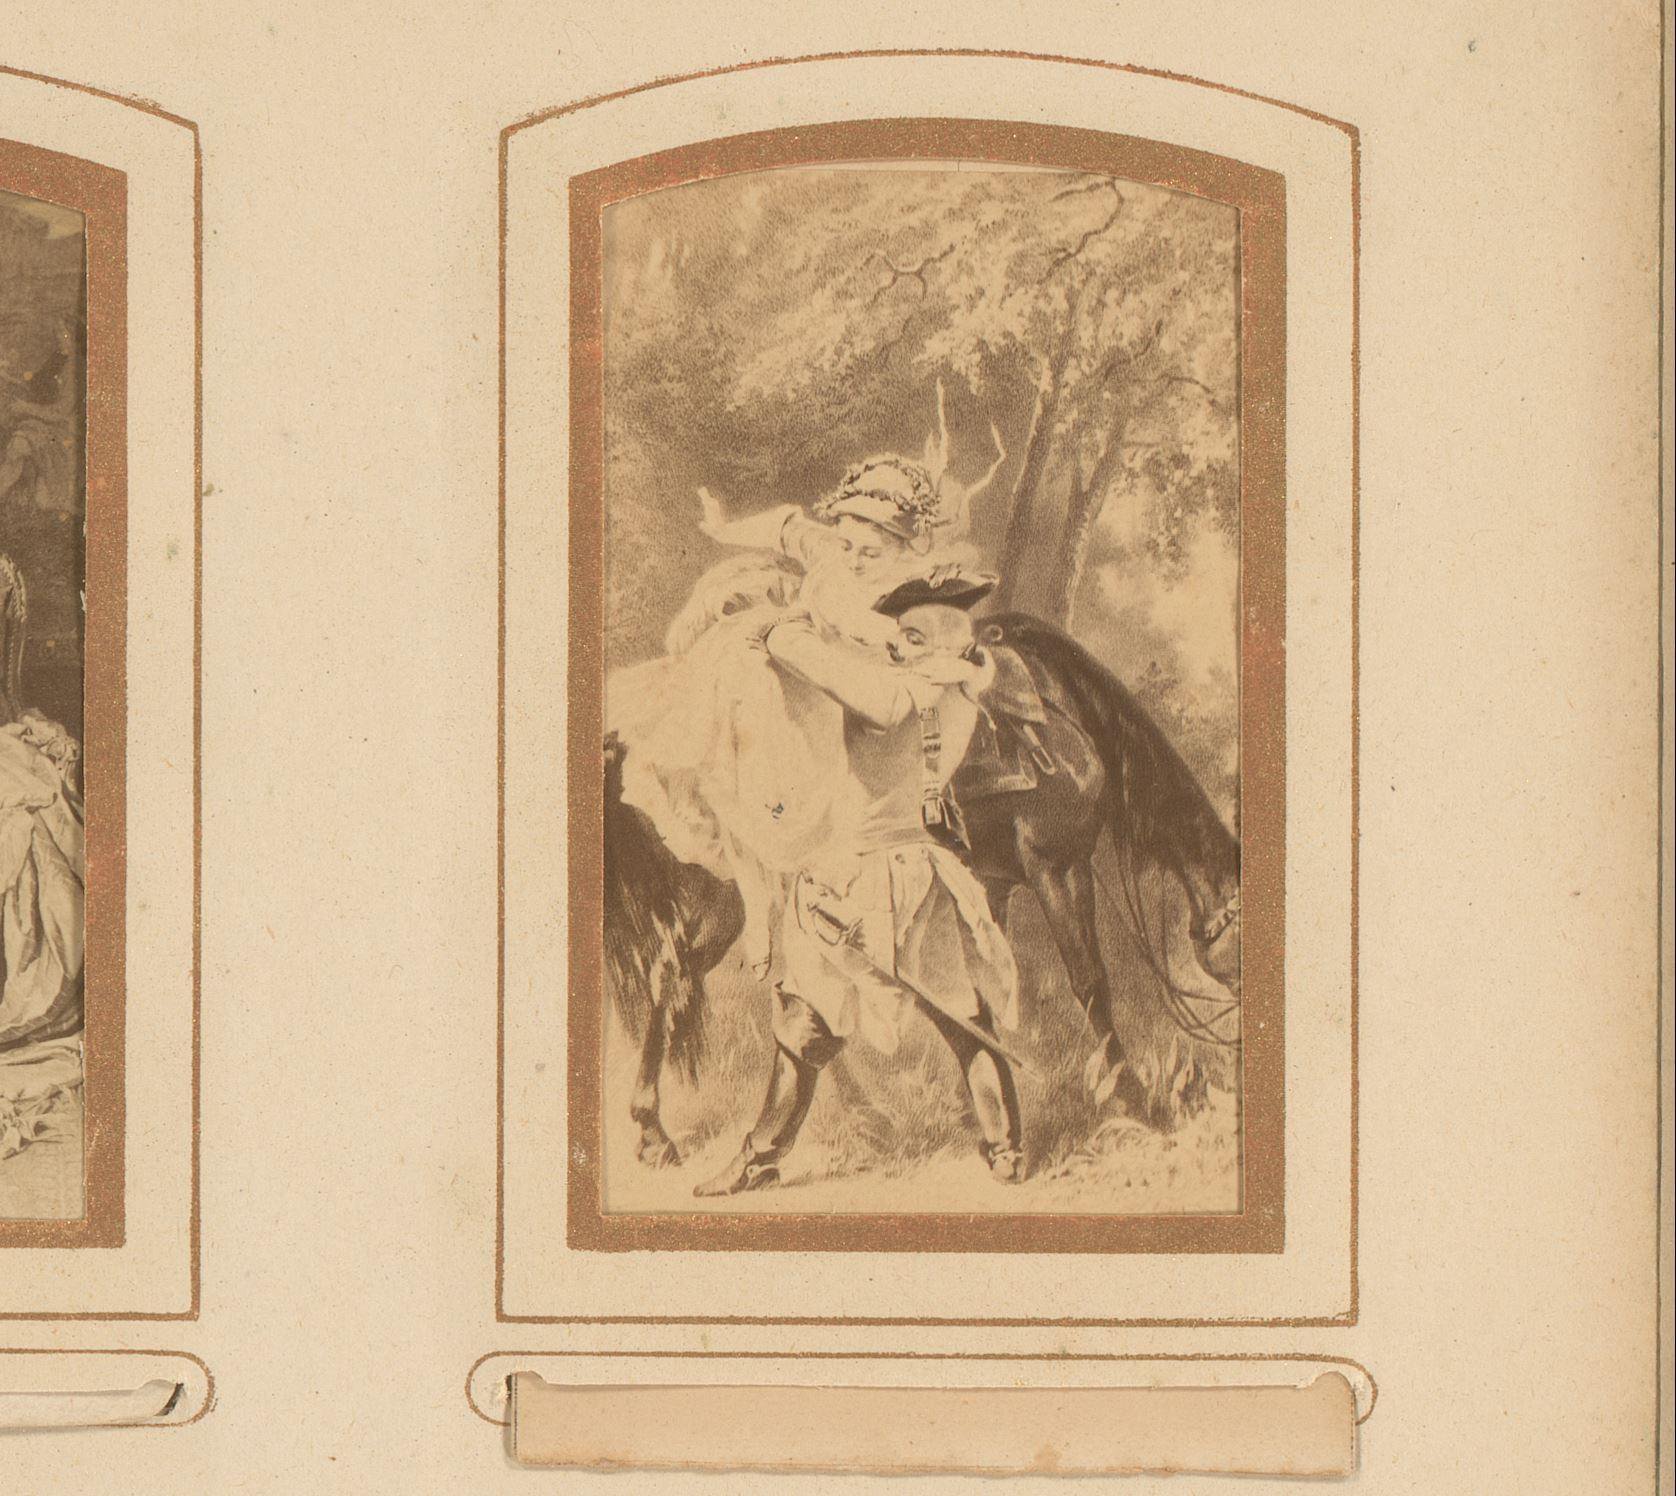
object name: photograph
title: Fotoreproductie van een schilderij van een man die een vrouw van een paard trekt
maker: Anonymous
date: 1850-1900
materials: cardboard, photographic support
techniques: albumen print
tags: drawing, pulling something, adult woman, adult man, horse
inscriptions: annotation: ‘l'heureuse Etape’